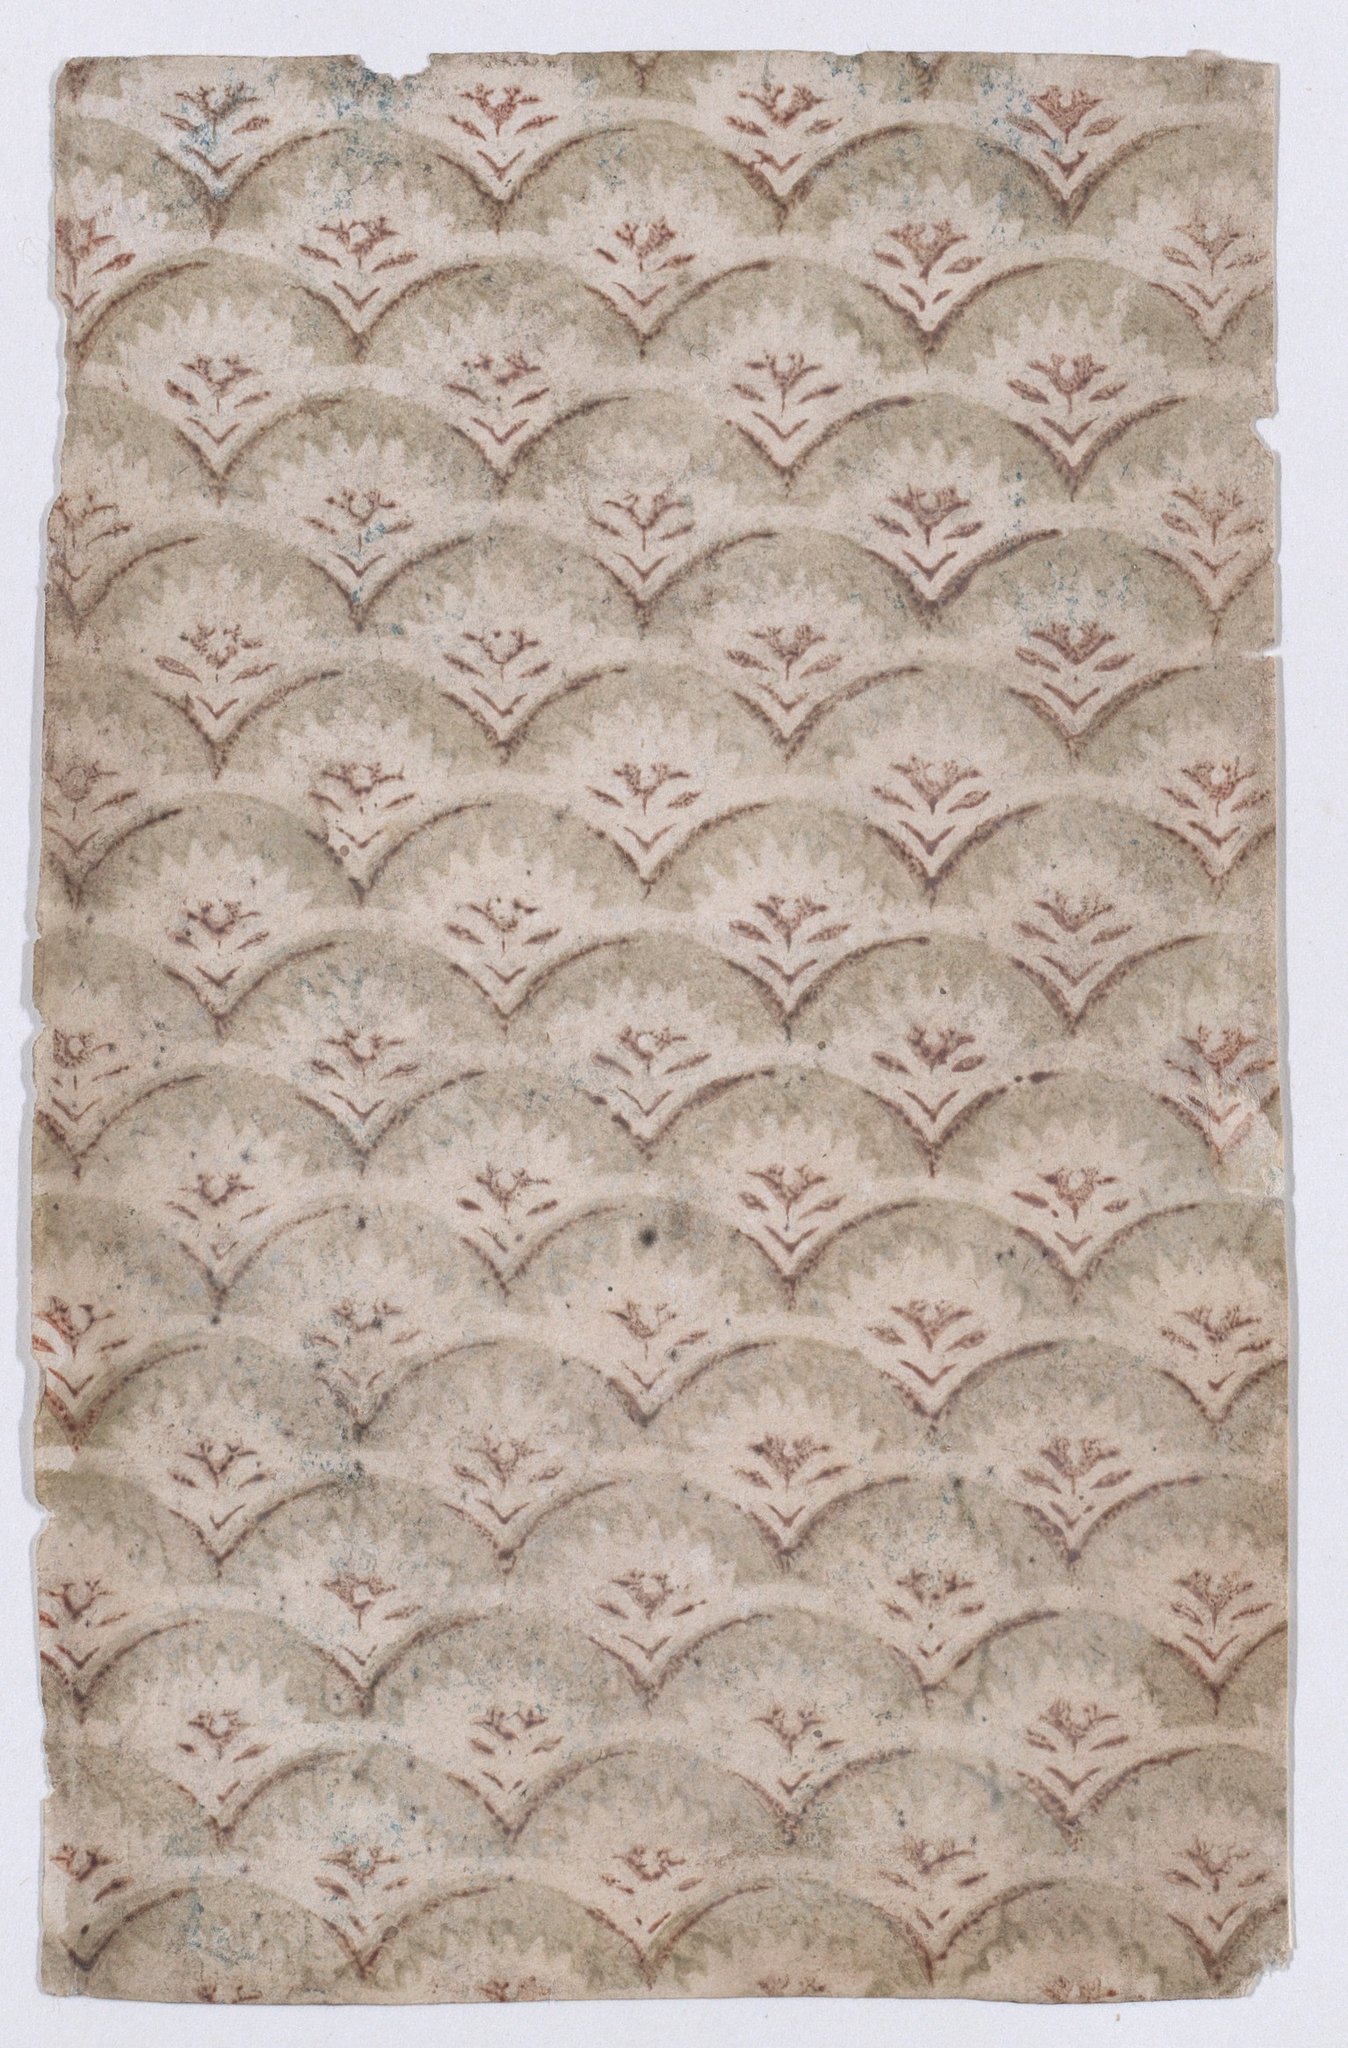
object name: print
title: Sheet with overall curved abstract pattern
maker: Anonymous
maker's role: artist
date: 1801-1900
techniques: relief print